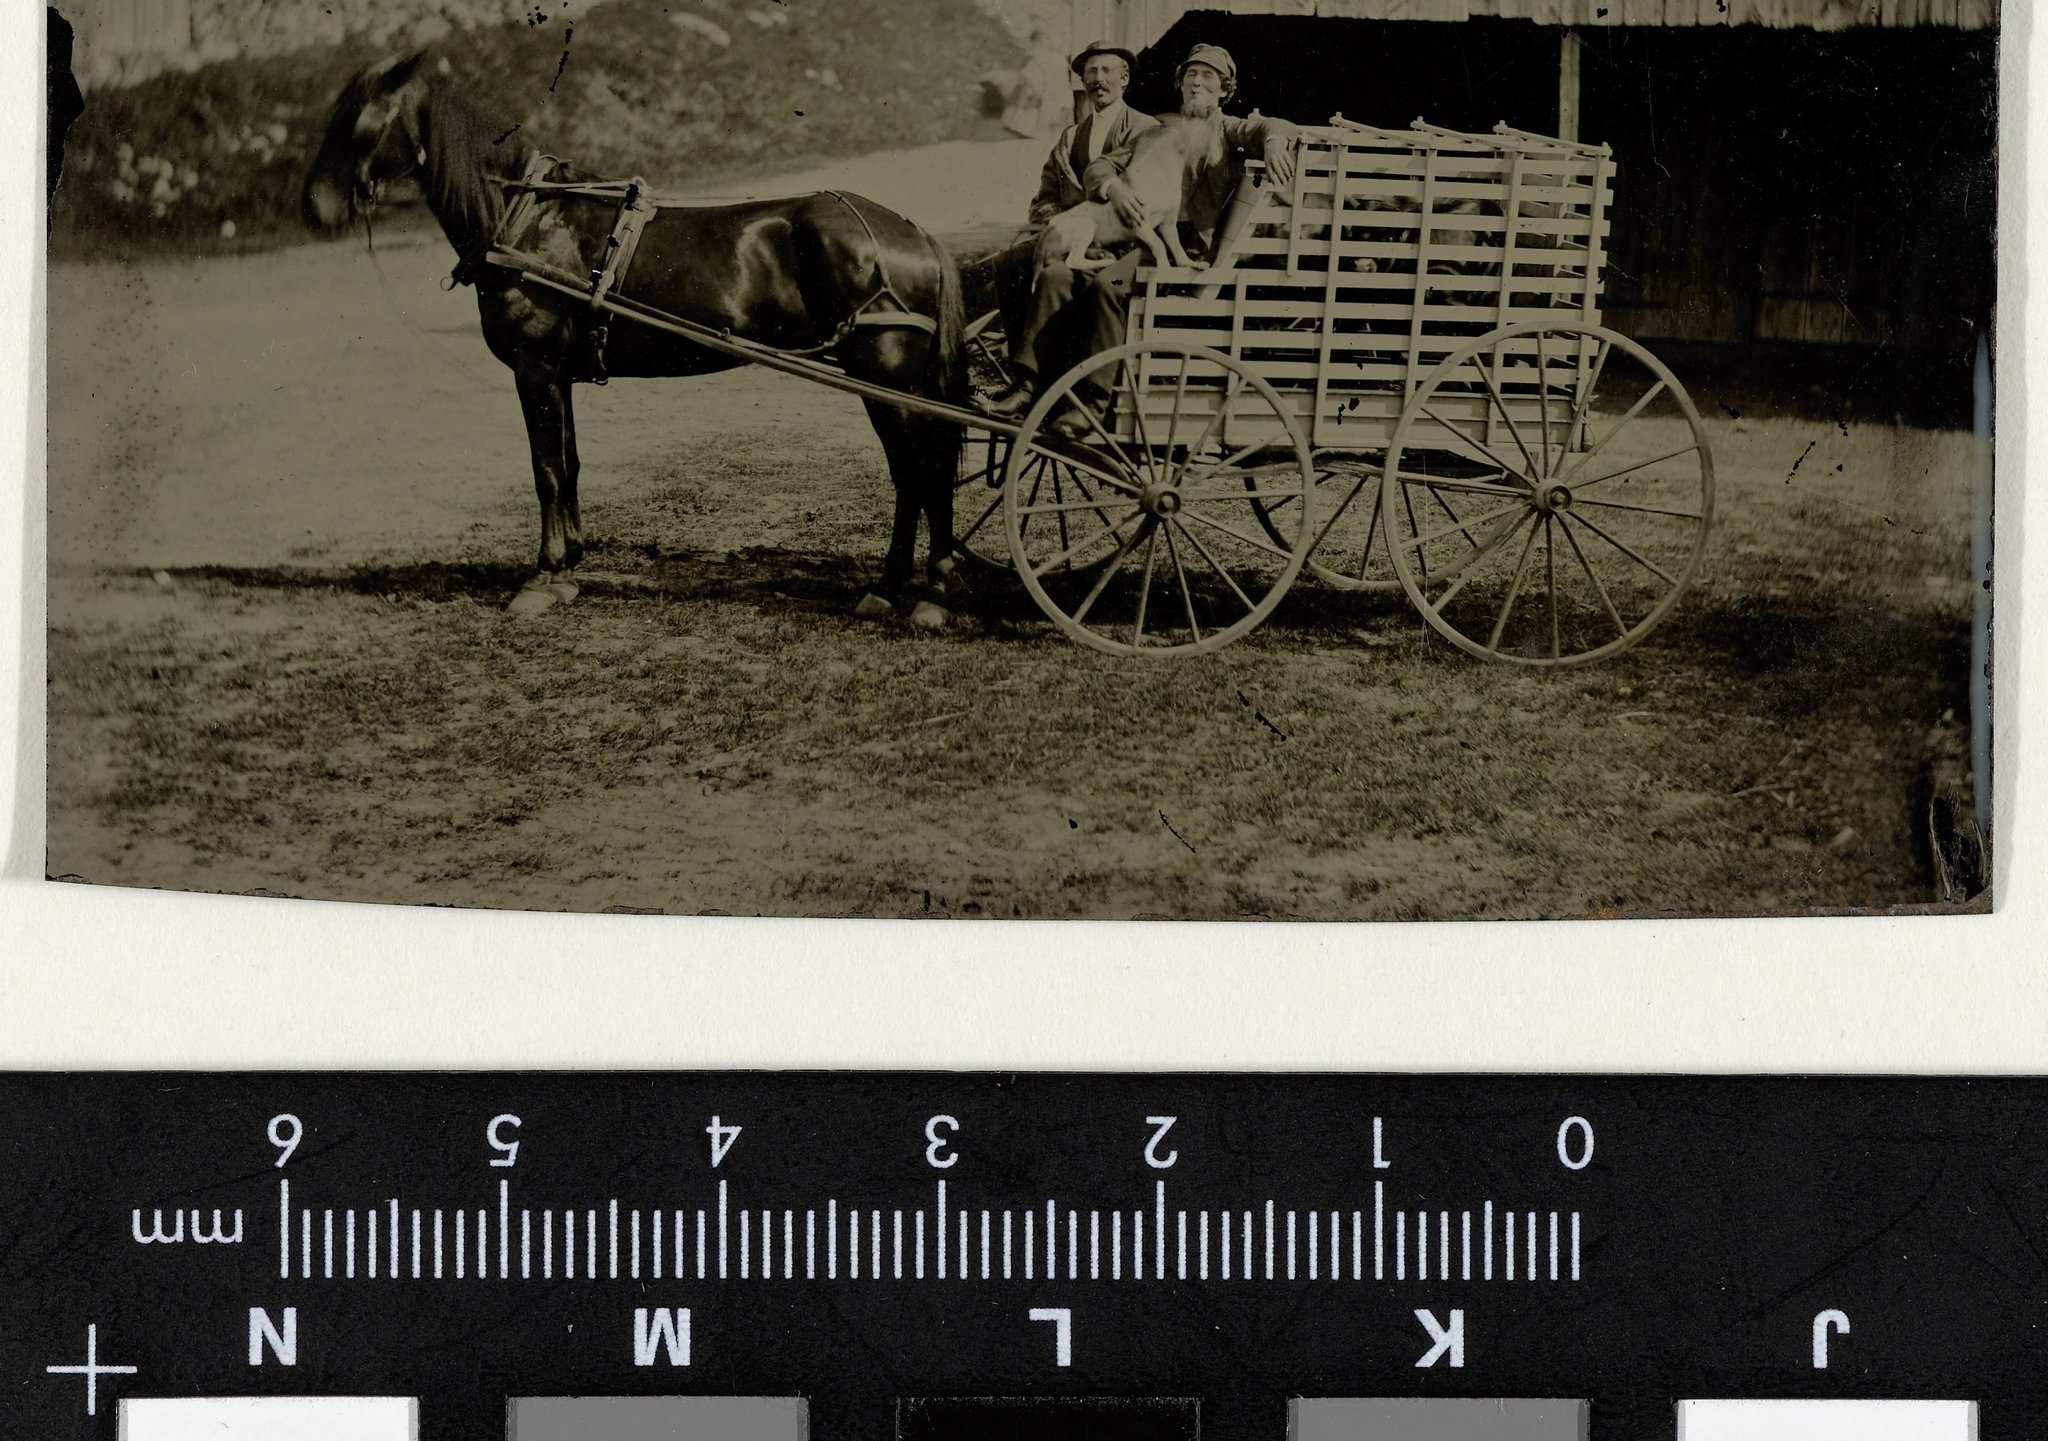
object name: photograph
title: Paard en wagen en twee mannen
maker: Anonymous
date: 1870-1890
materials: metal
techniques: ferrotyping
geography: united states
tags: four-wheeled, animal-drawn vehicle, e.g.: cab, carriage, coach, united states of america